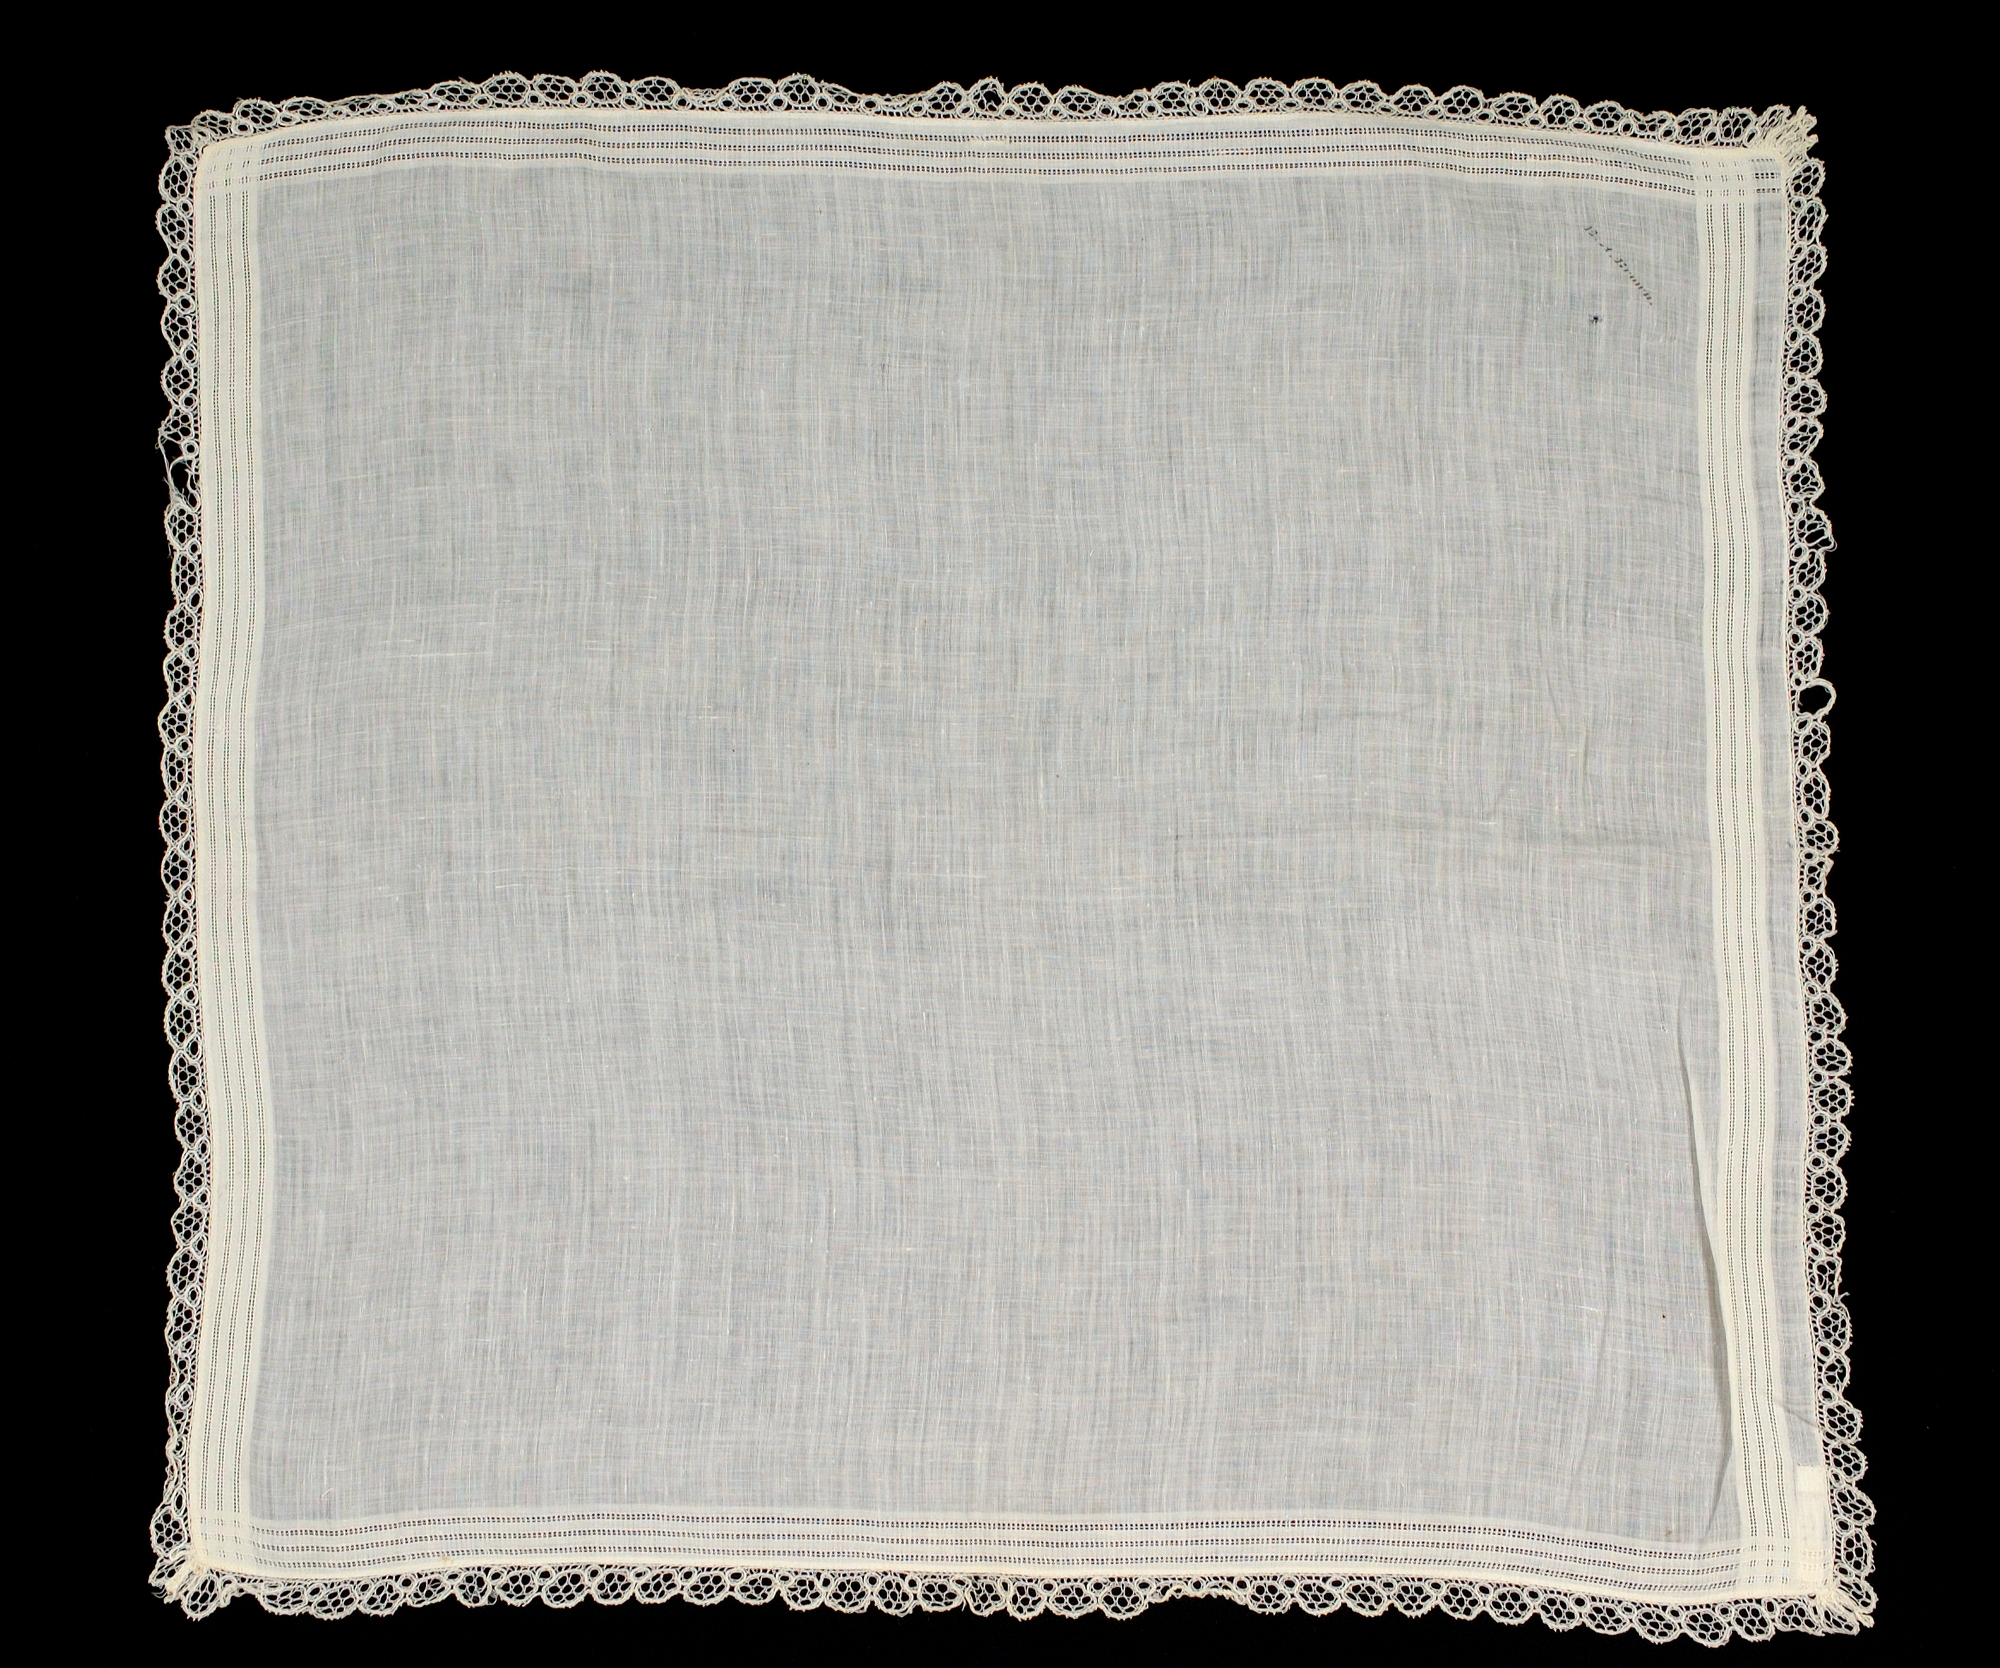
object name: handkerchief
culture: american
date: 1840-1860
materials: linen